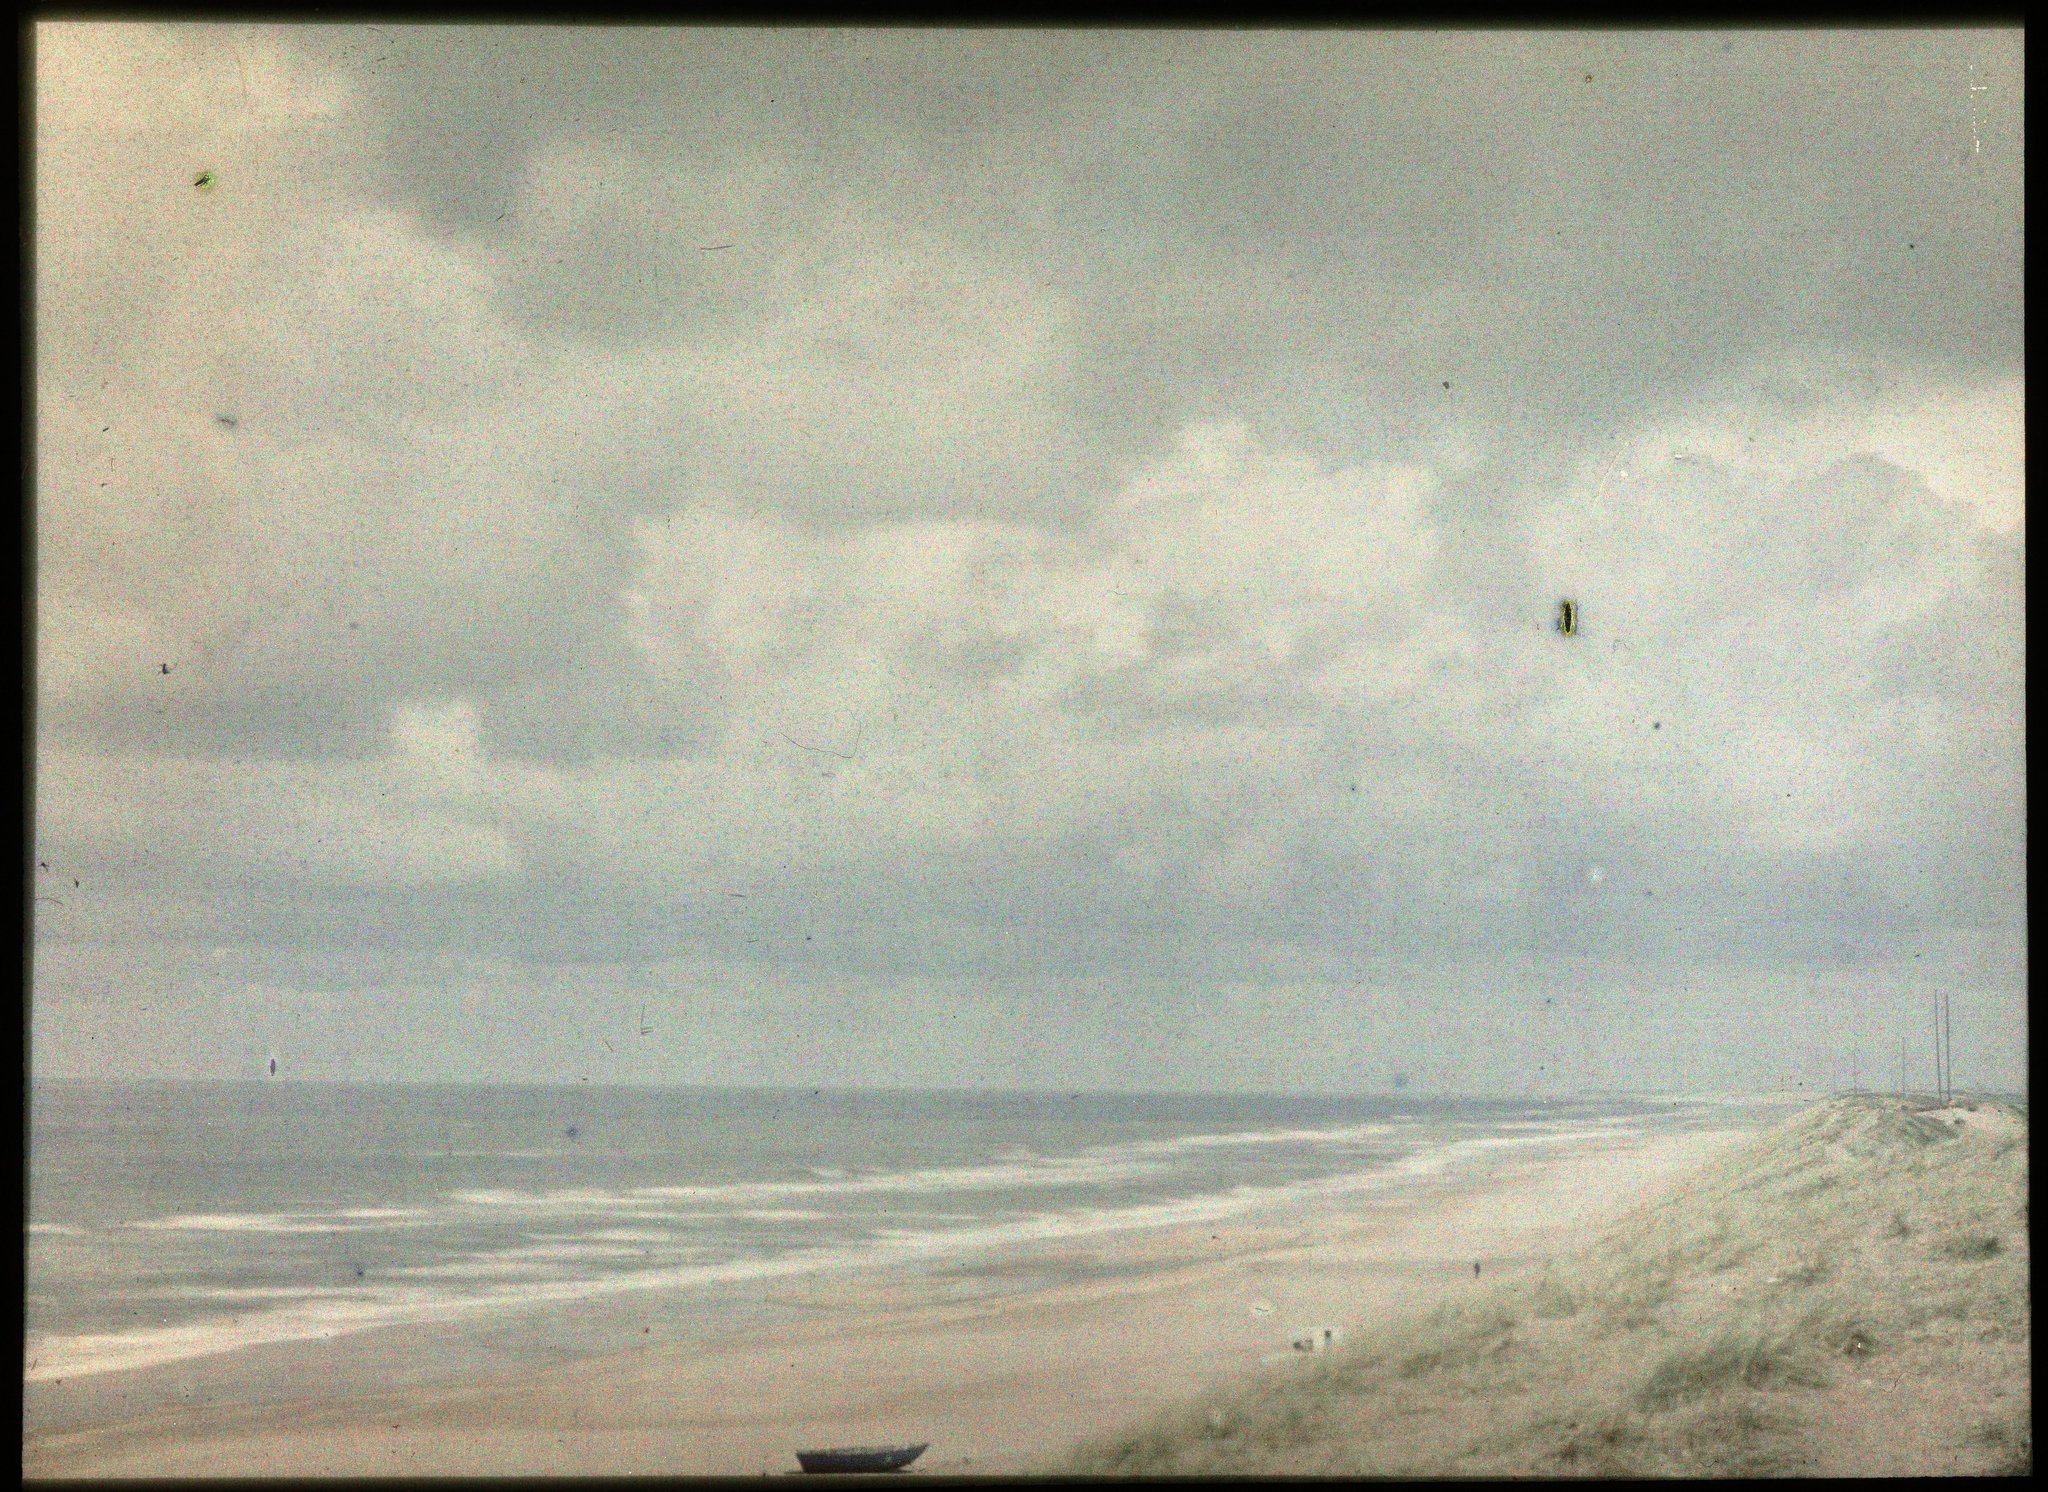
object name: color slide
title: Gezicht (vanaf een duin) over het Noordzeestrand, met rechtsonder helmgras en middenonder een sloep op het strand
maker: adolphe burdet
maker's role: fotograaf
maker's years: 1860-1940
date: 1907-1930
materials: glass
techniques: autochrome process, slide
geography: netherlands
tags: noordzee